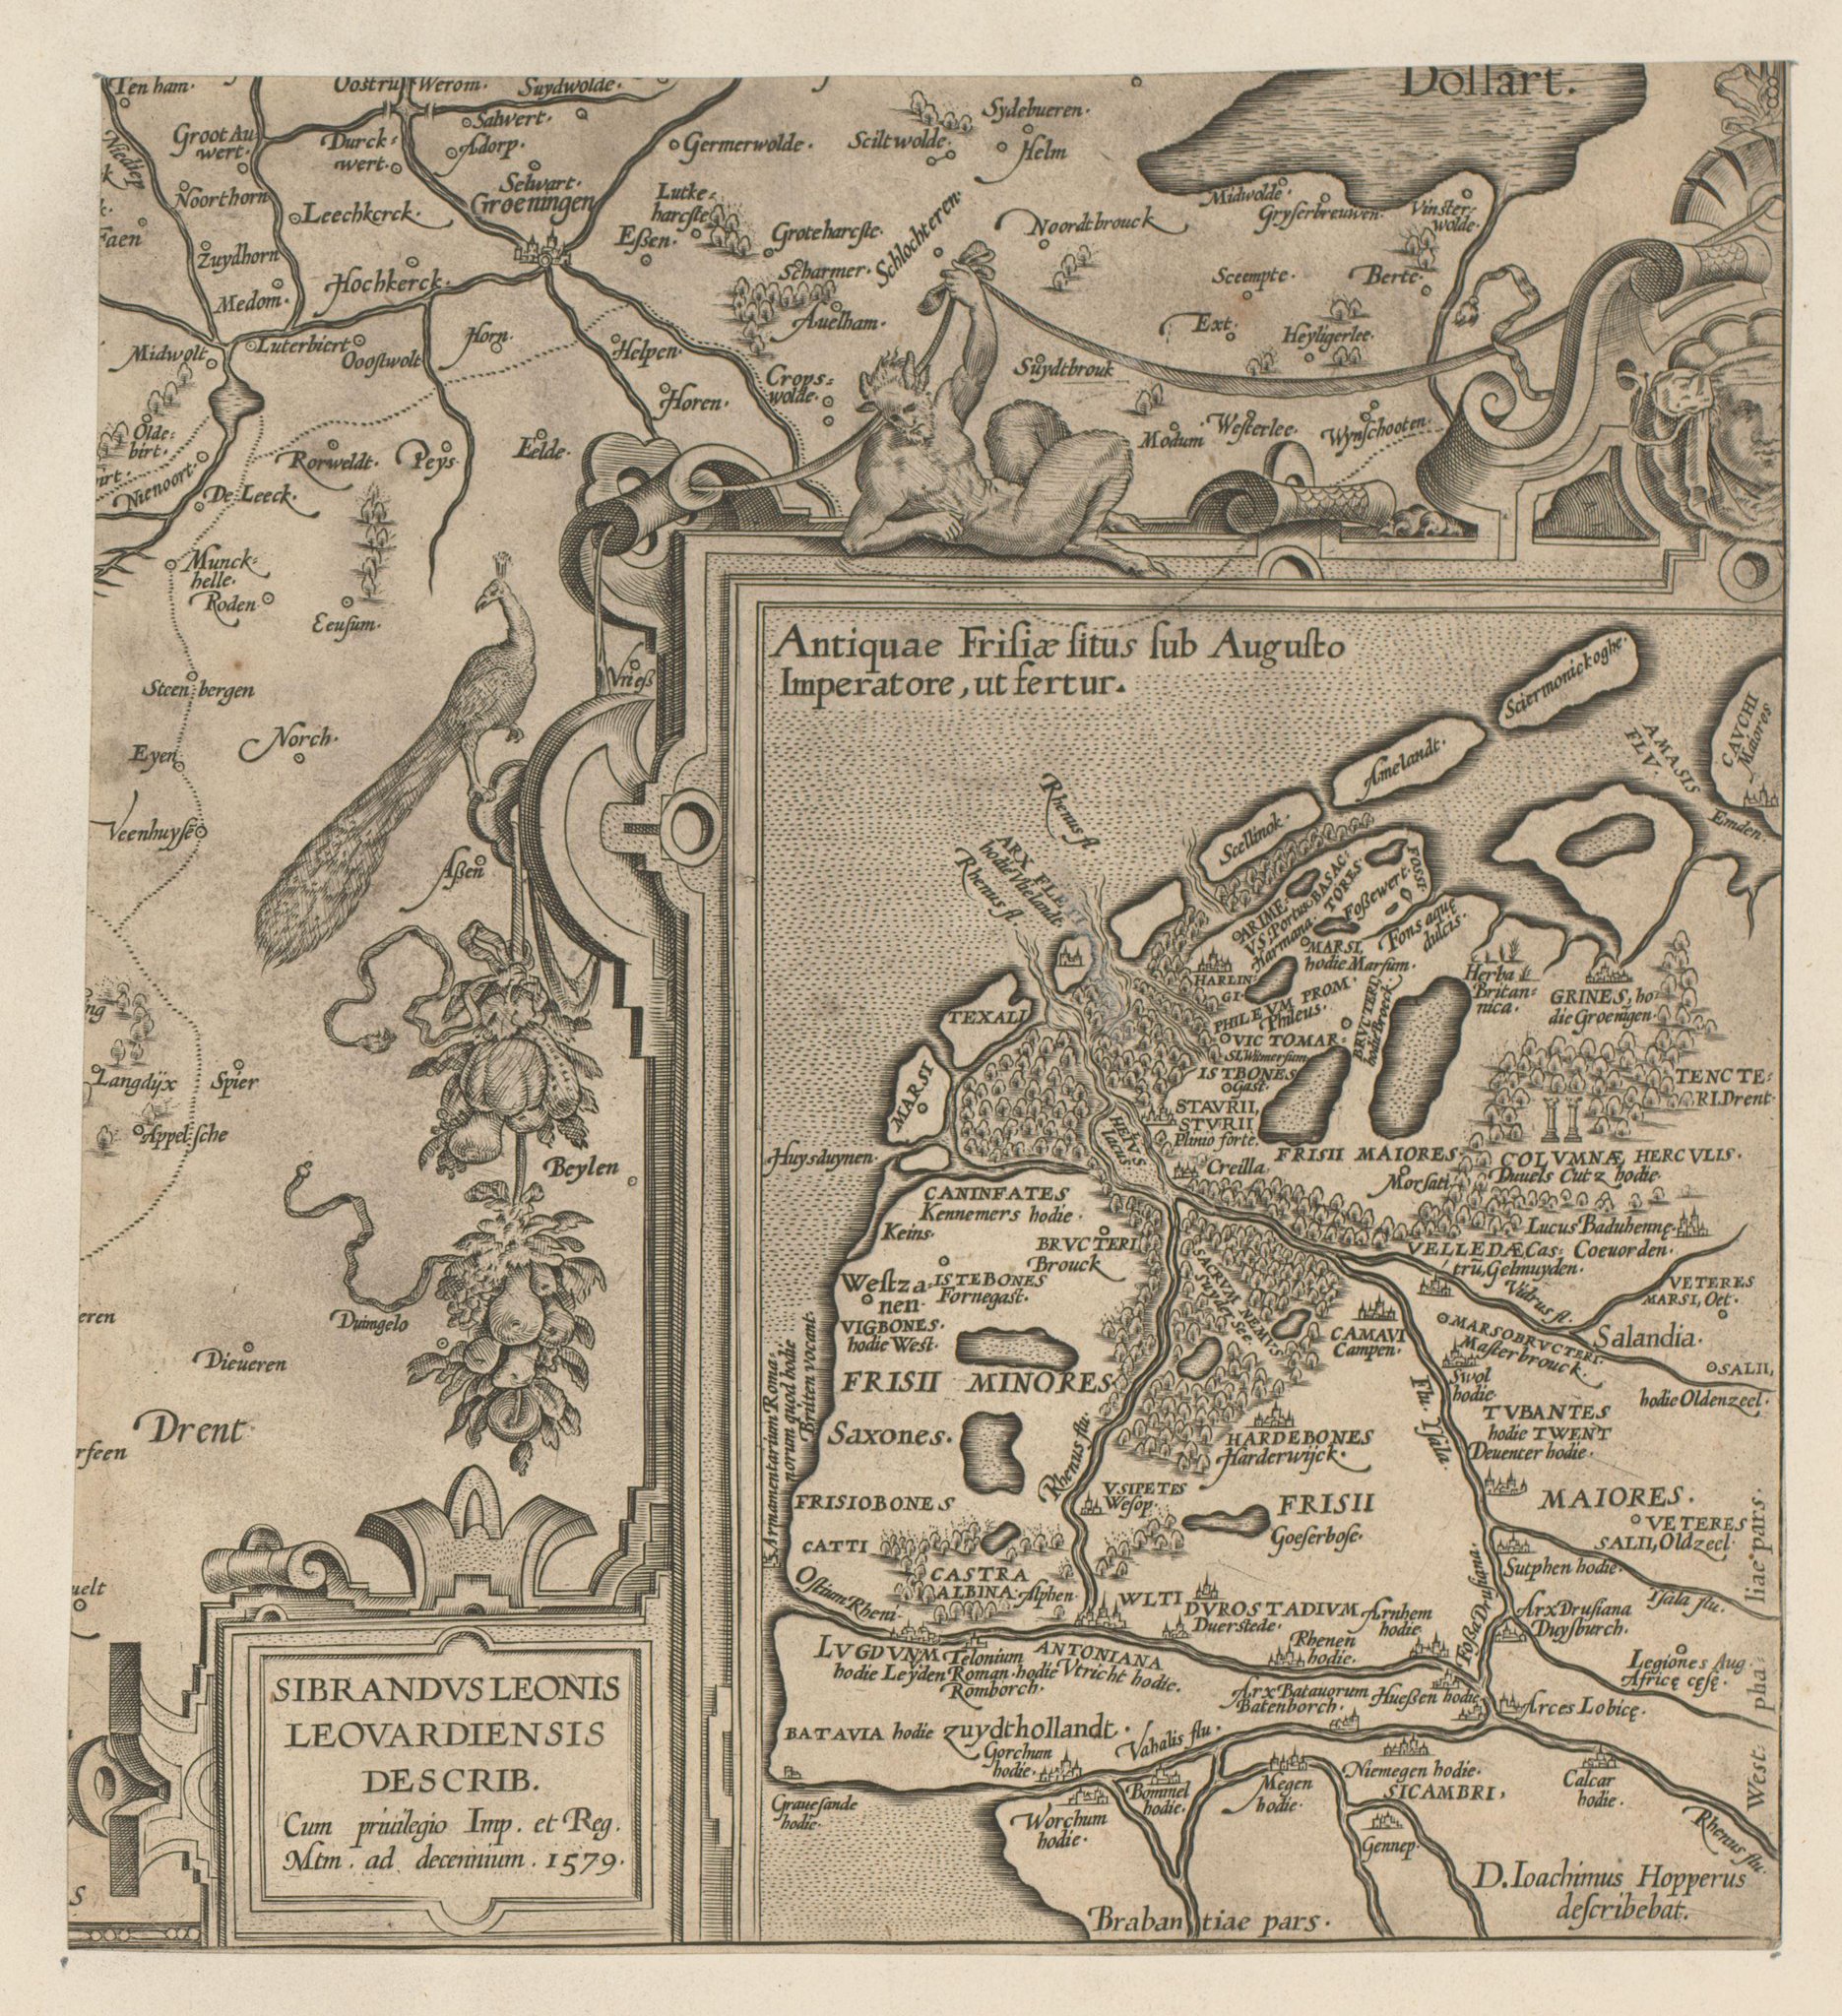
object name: album leaf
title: Frisia Occidentalis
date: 1579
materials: paper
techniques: engraving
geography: antwerp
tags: ornaments ~ art, fruits and vegetables ~ ornament, maps, atlases, ornamental birds: peacock, ornament ~ cartouche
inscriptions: date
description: Rechthoekige cartouche met een kaart van Oud-Friesland. Bovenop een sater en links een pauw en trossen fruit. De prent maakt deel uit van een album.